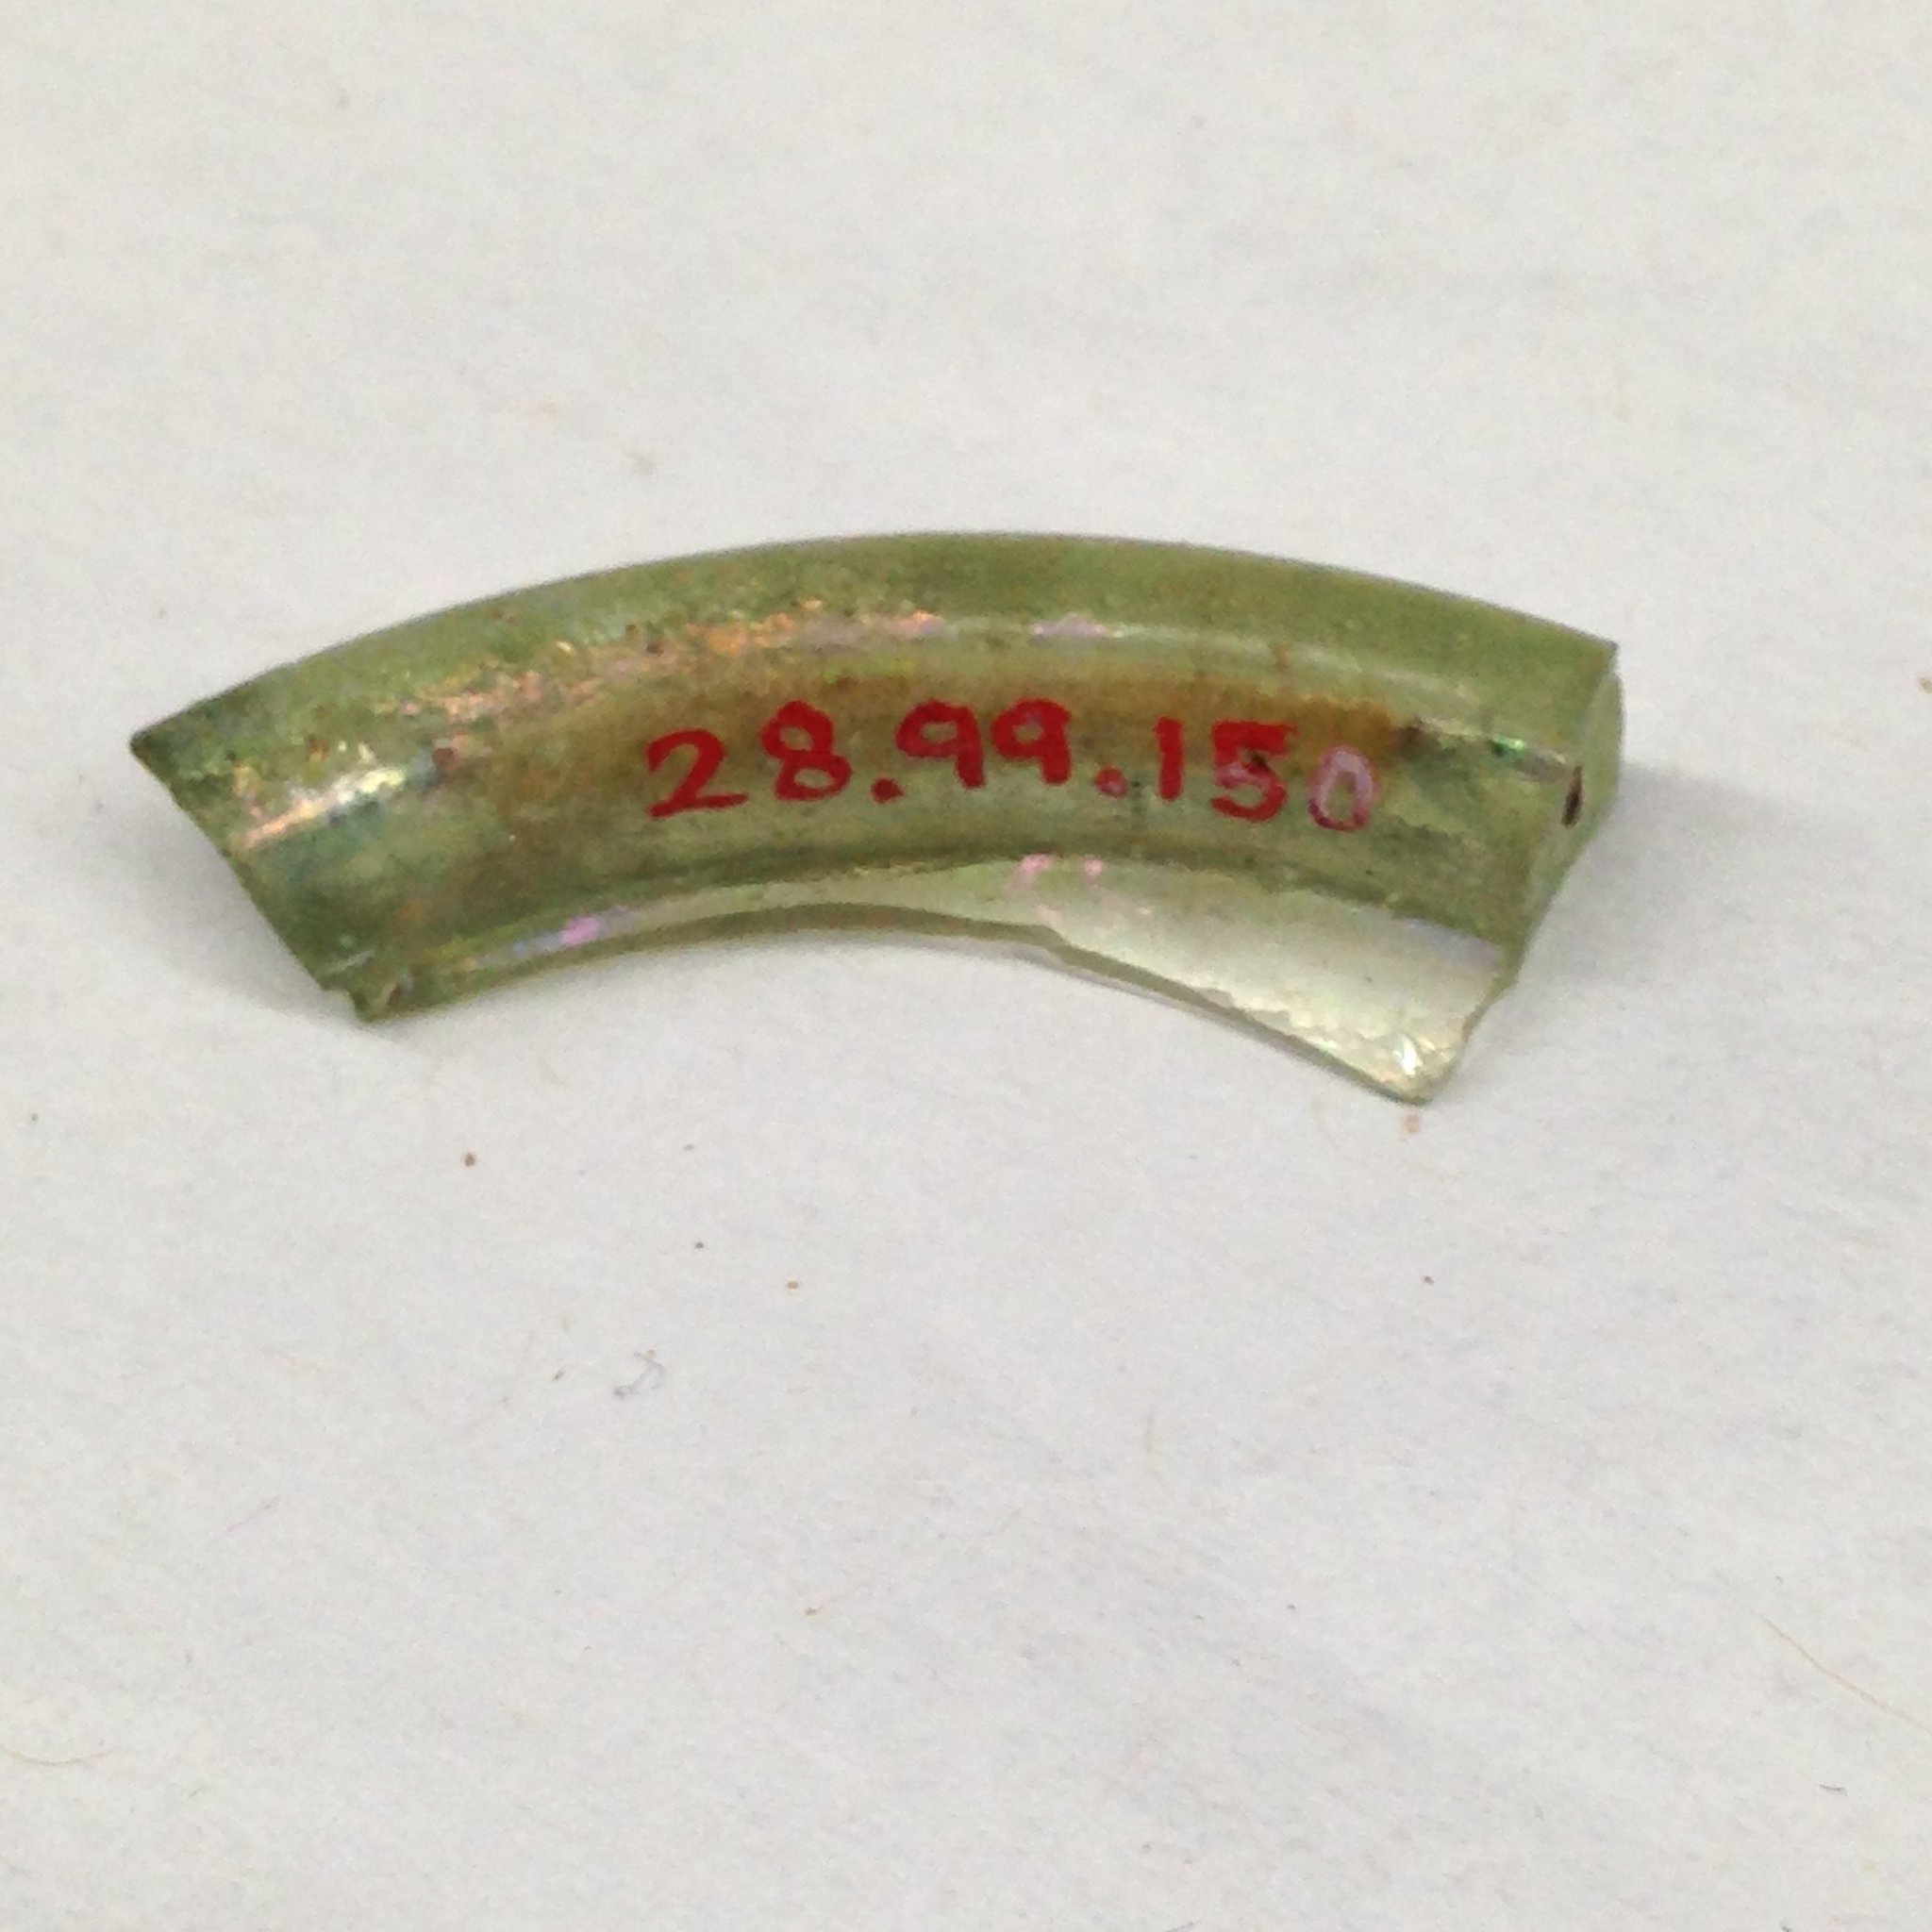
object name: fragment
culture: european or middle eastern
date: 1150-1250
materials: ceramic, glass